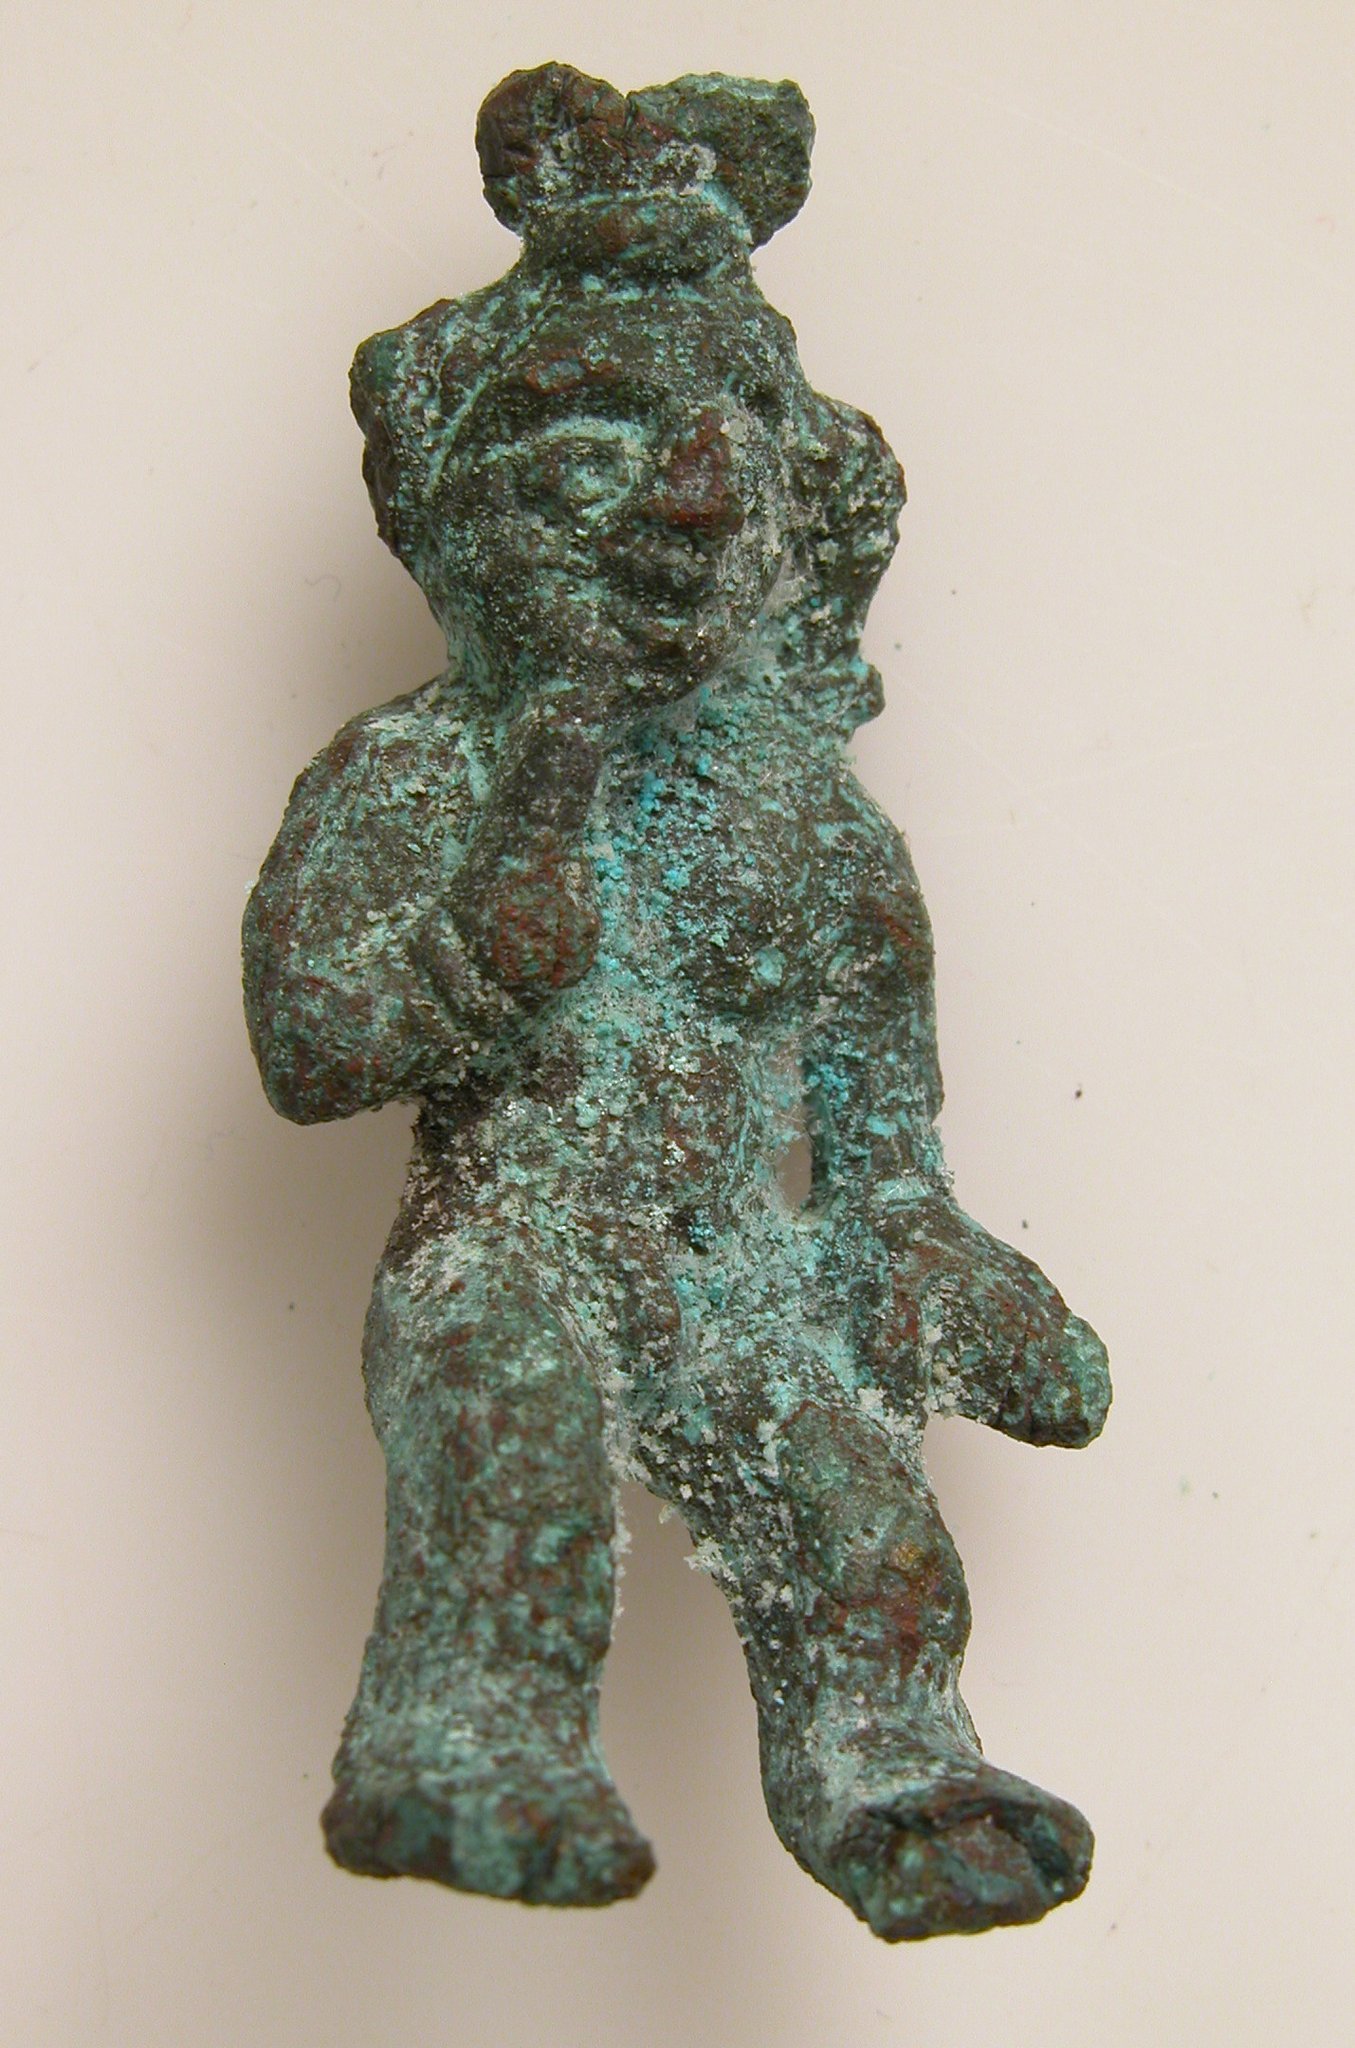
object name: statuette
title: Figure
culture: coptic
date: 301-700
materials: copper alloy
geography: egypt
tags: human figures